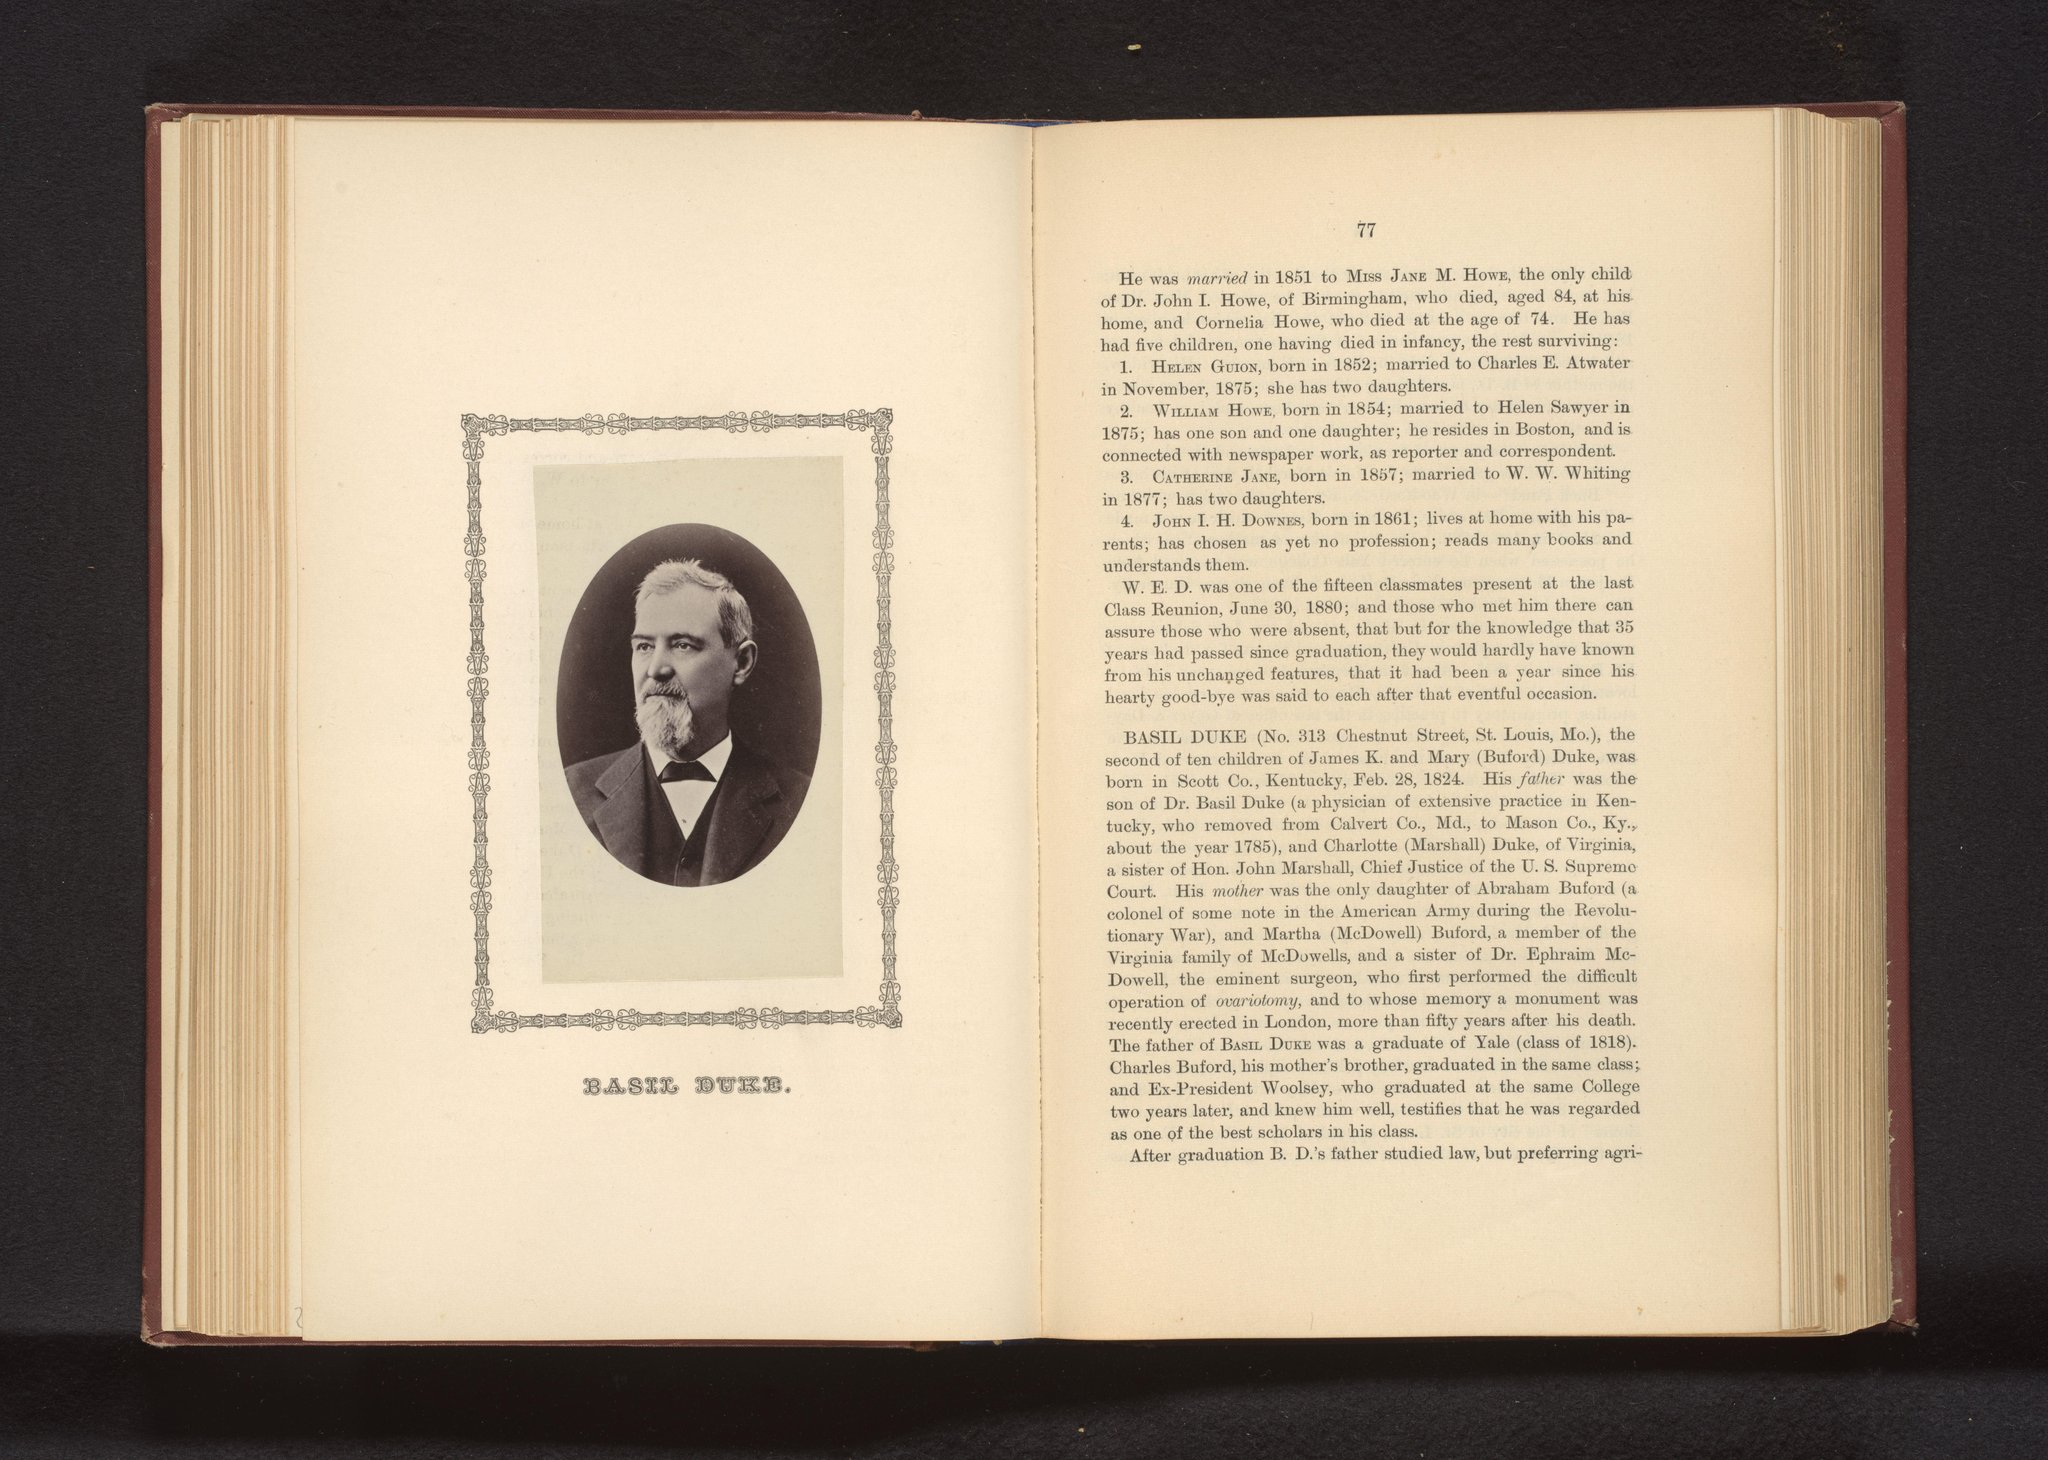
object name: page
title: Basil Duke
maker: Anonymous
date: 1876-1881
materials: photographic support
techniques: albumen print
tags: adult man